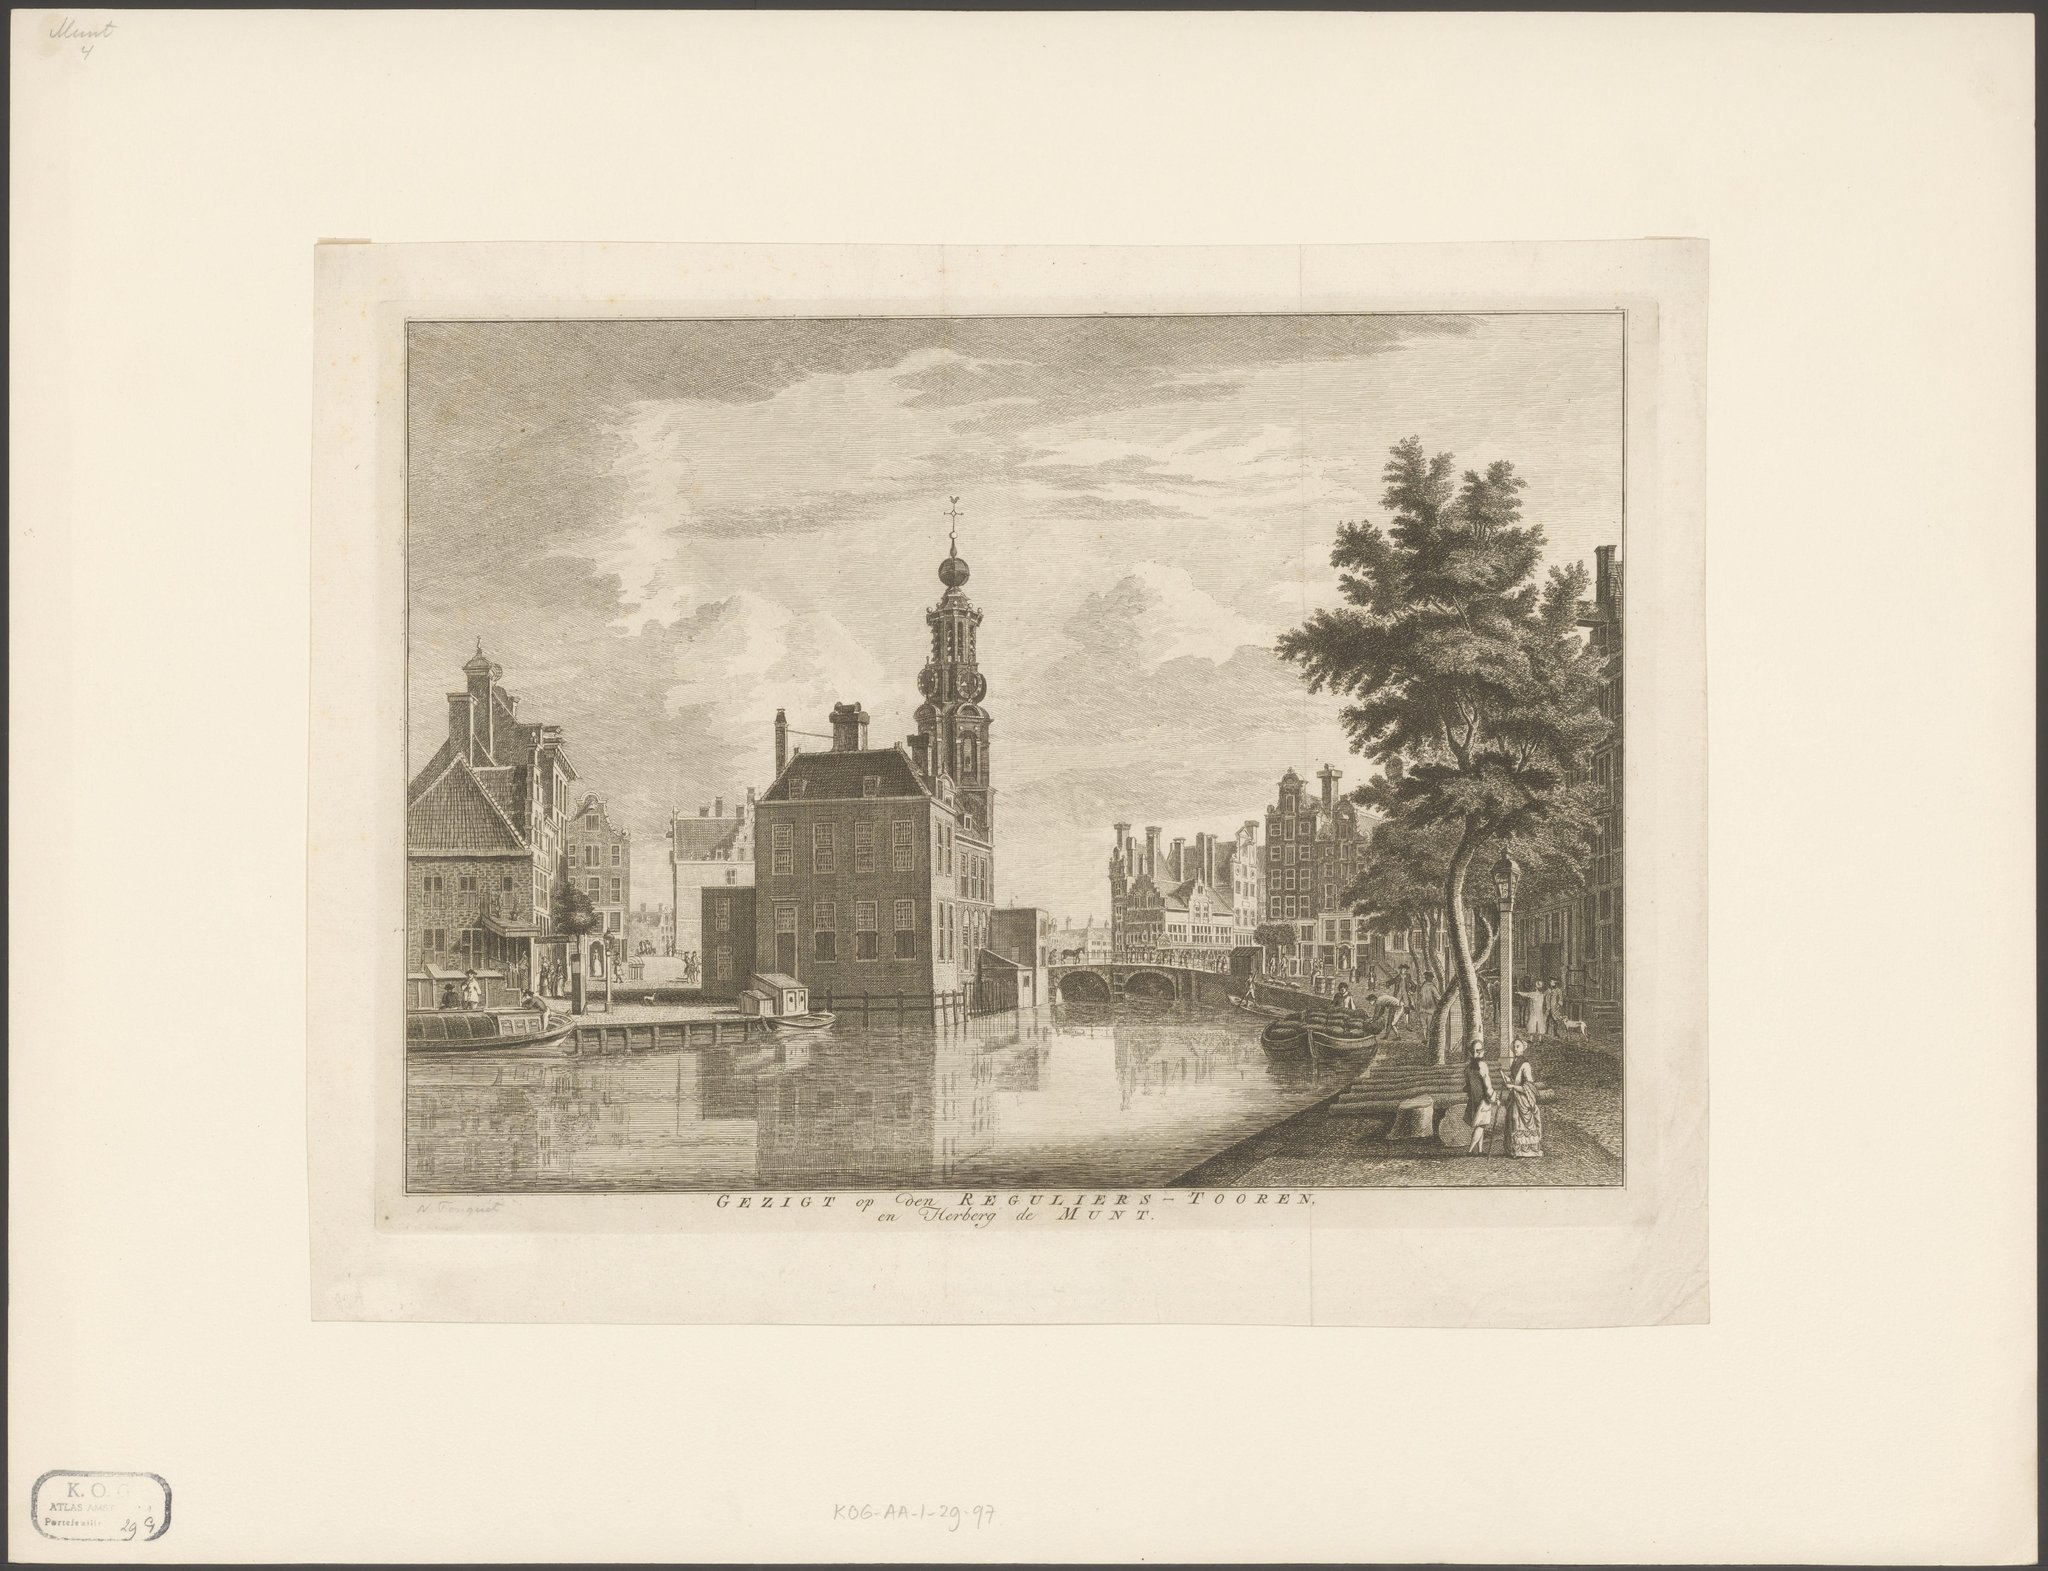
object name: print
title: Gezicht op de Munttoren te Amsterdam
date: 1765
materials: paper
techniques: engraving, etching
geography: northern netherlands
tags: bridge in city across river, canal, etc. (+ city(-scape) with figures, staffage), tower, clock tower ~ monumental adornment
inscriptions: collector's mark: Lugt 1641b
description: Prent mogelijk uit: Wagenaar, Jan. Amsterdam, in zyne opkomst, aanwas, geschiedenissen (…). Amsterdam: Isaak Tirion, 1765, dl. 2.